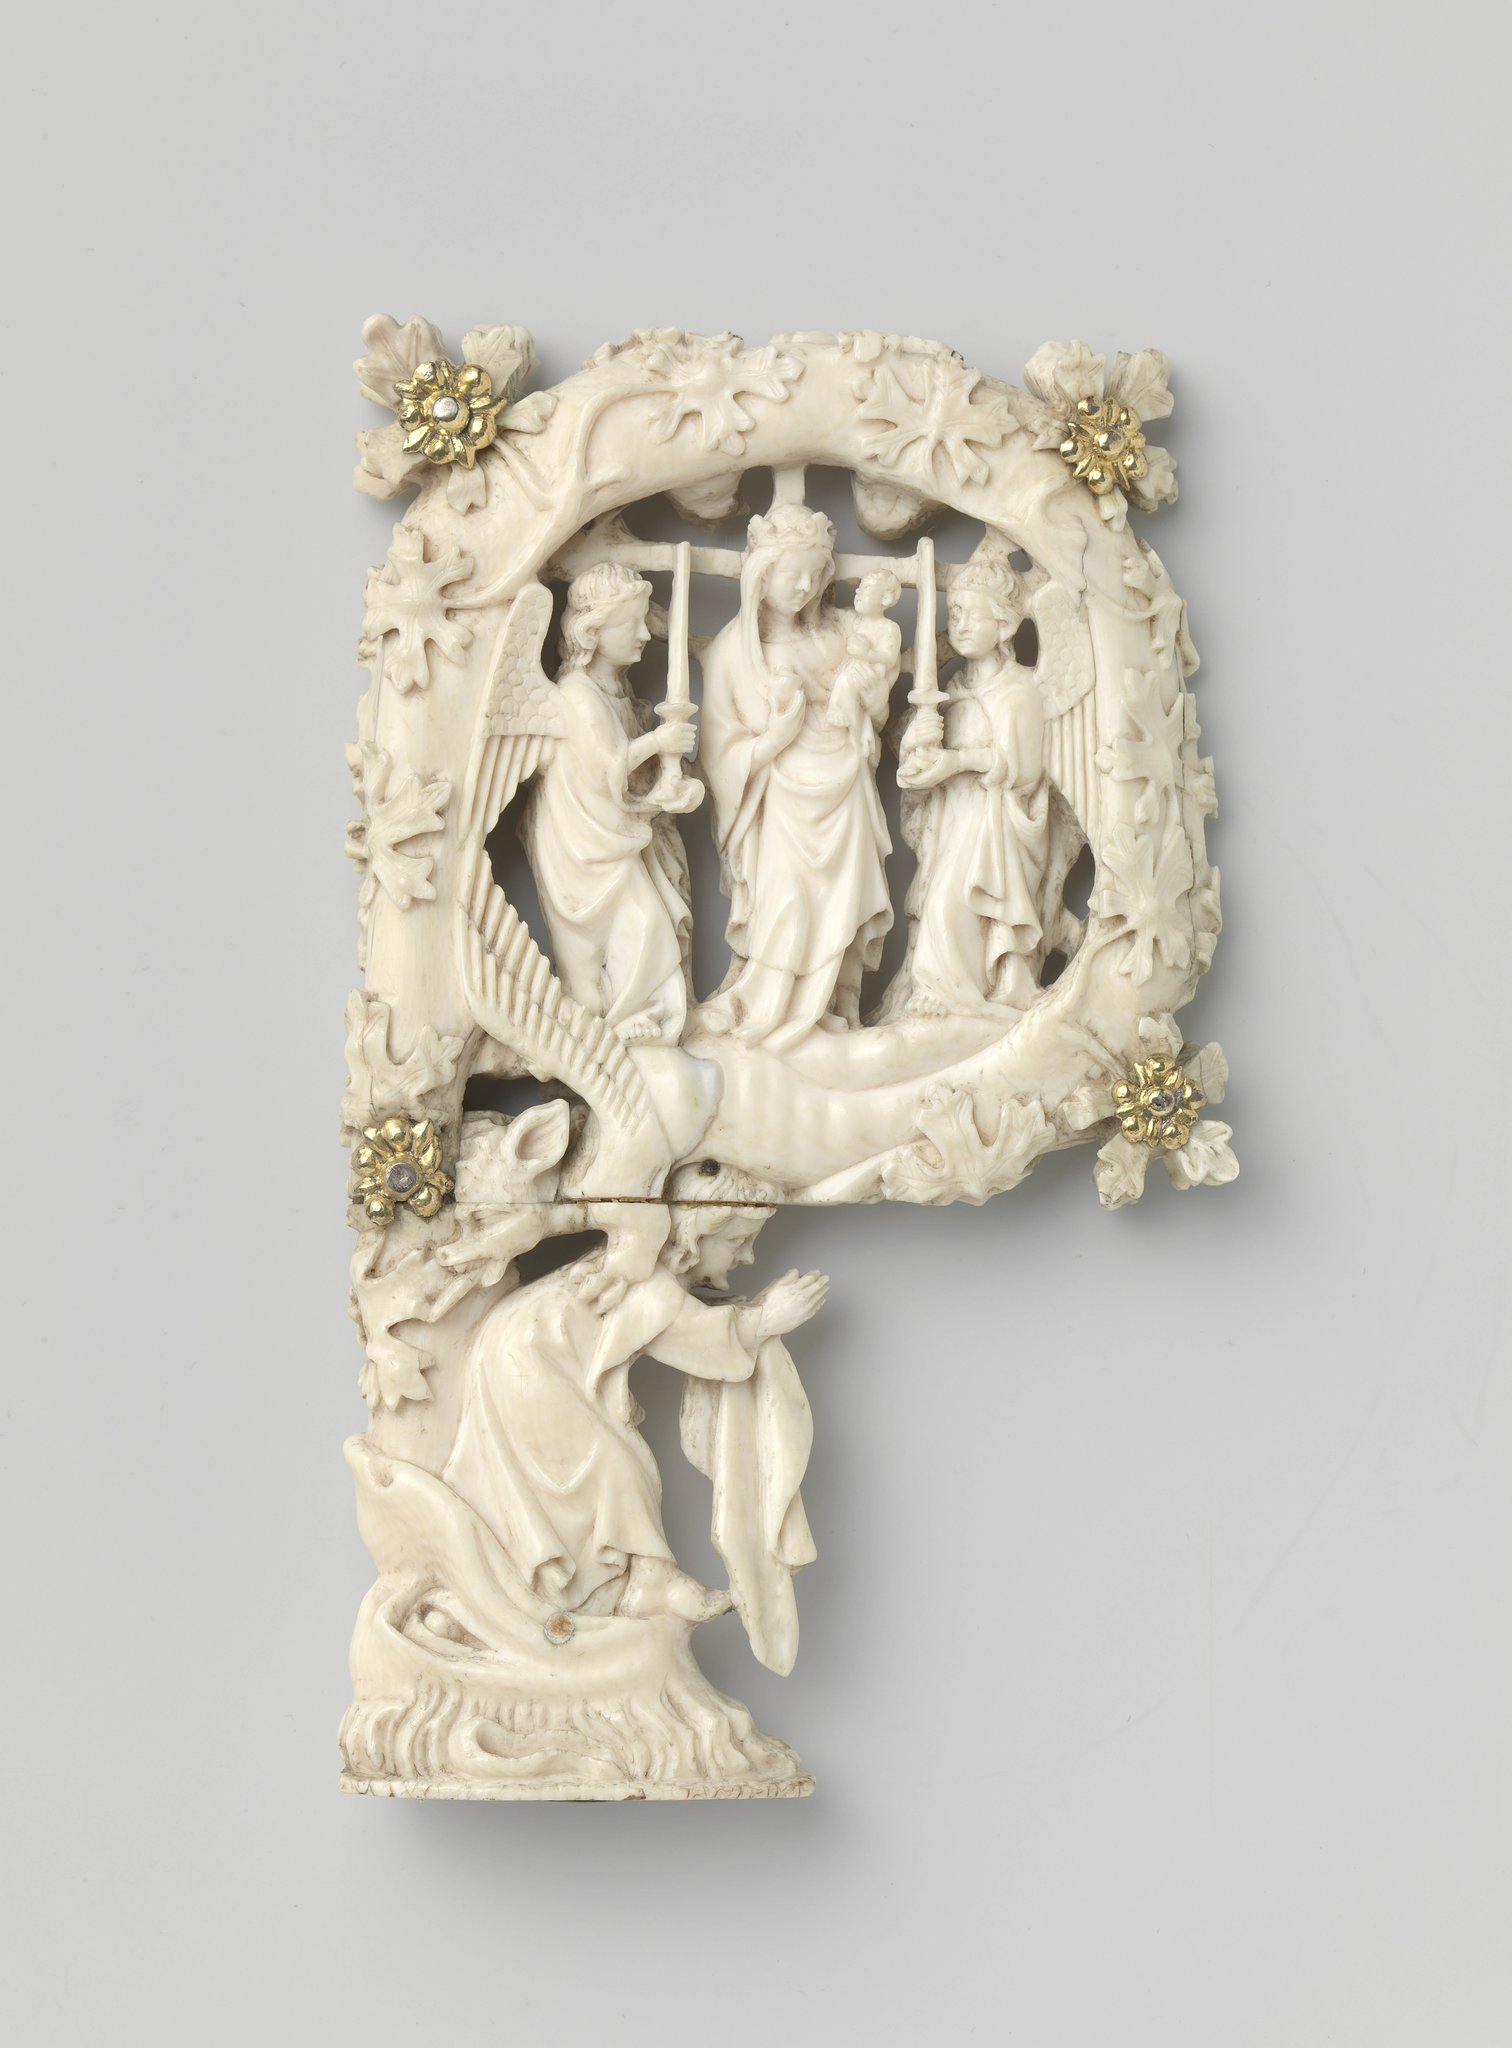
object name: kromstaf, bisschopsstaf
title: Crozier head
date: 1375-1400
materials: ivory, silver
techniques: cutting, gilding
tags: mary standing (or half-length), the christ-child on her arm (christ-child to mary's left), angel(s) with torch, crucified christ with mary and john on either side of the cross; holy rood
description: Uit een opengesperde leeuwemuil ontspruit een bebladerde twijg van een wijnstok, die zich in een krul ombuigt en eindigt in een draak, waarvan de kop met uitgestoken tong en de toppen van zijn uitstaande vleugels weer aan het onderste deel van de twijg aansluiten. De klauwen van de draak rusten op de schouders van een voorover gebogen, van de twijgstam afgewende jongeling, die de handen in biddende houding naar voren steekt en met beide voeten op de onderkaak van de leeuwenmuil staat. In de krul zijn afgebeeld Christus met aureool aan het kruis tussen Maria en Johannes. Het doorgezakte lichaam van Christus is naar Maria toegewend die, naar hem opziende, beide handen gebarend openhoudt. Johannes draagt een boek en staart met de vingers van de rechterhand tegen de kin peinzend naar Christus. Boven het kruis tegen de kromming van de wijnstok zon en maan. Op de keerzijde staat Maria met het kind op de linkerarm en met een vrucht in de rechterhand, tussen twee haar toegewende toortsdragende engelen. Het kind heeft zijn arm om haar schouders geslagen en houdt in de linkerhand een vrucht (?). Op elk der vier grote hoekbladeren van de wijnstok een rozet in zilver.